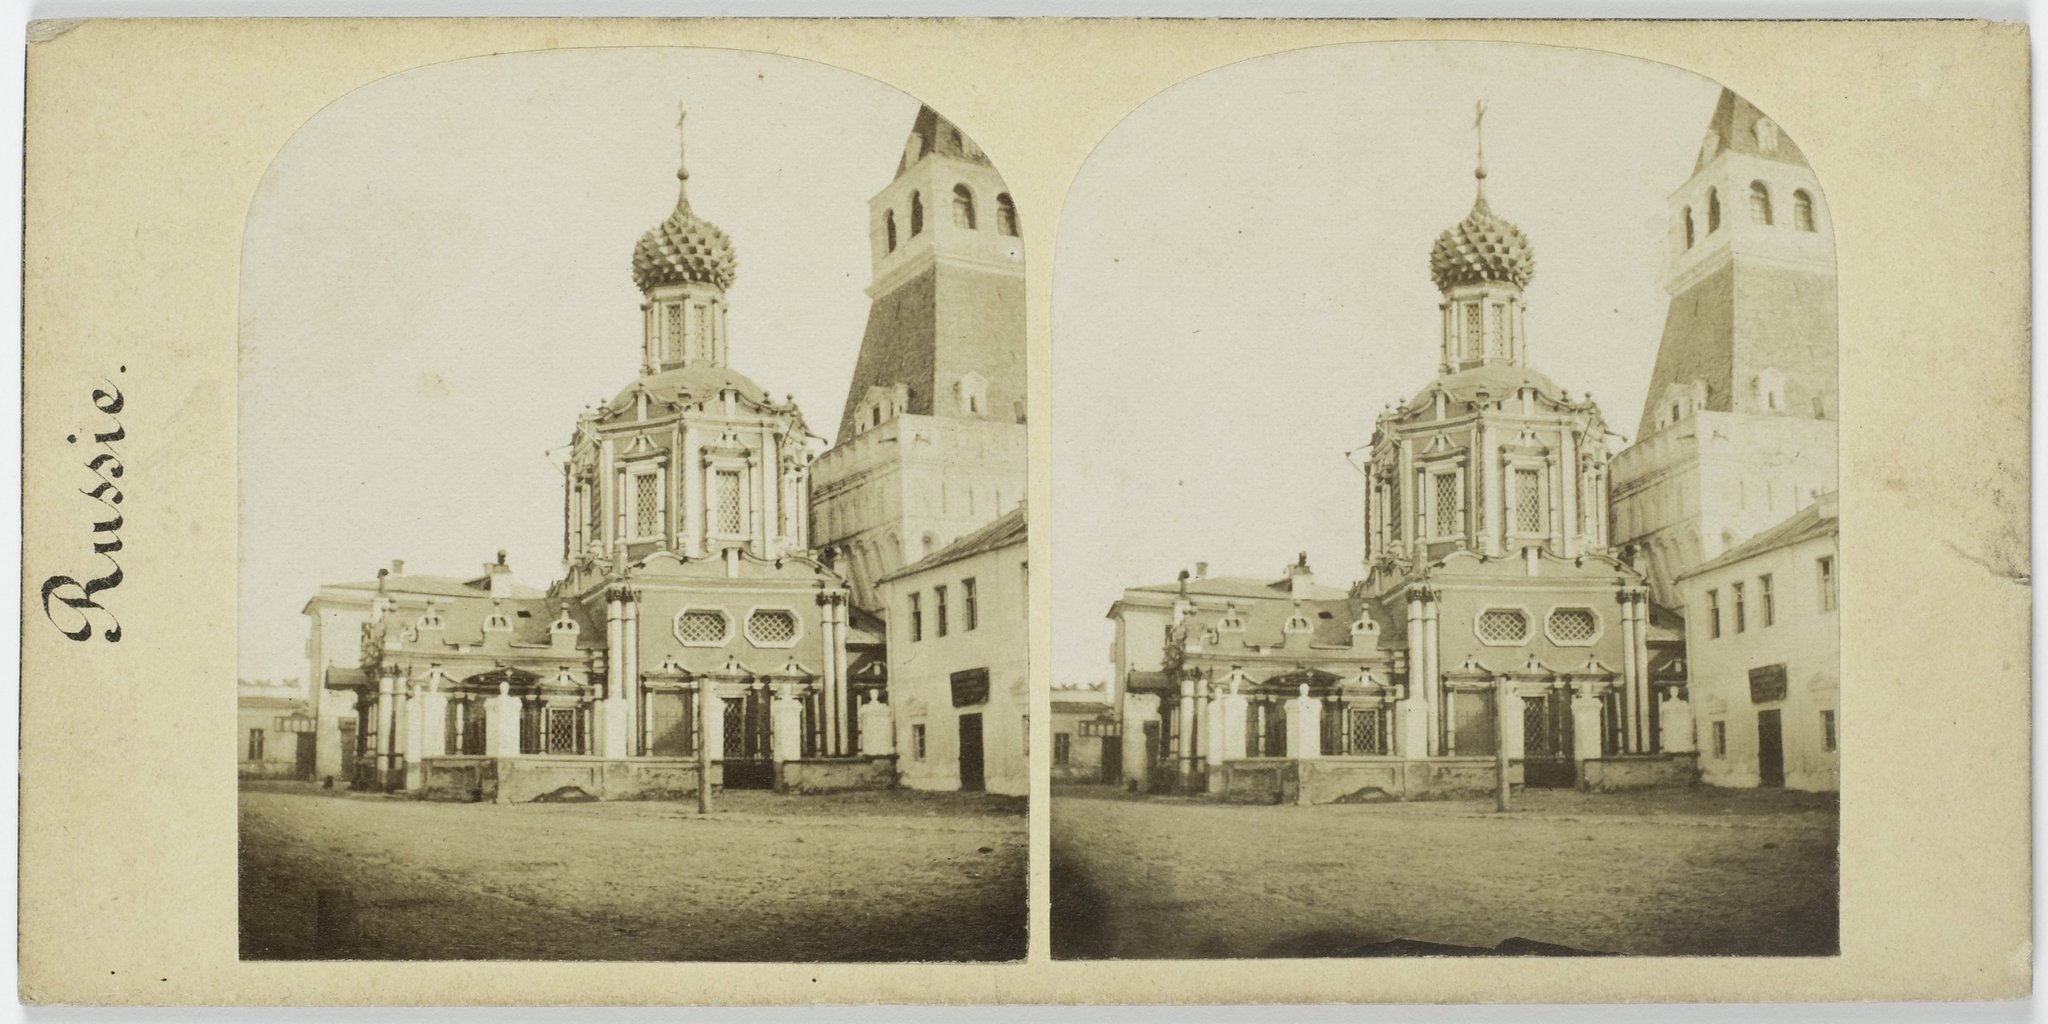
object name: stereograph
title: Exterieur van een kerk te Moskou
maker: Anonymous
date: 1850-1880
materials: cardboard, photographic support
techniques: albumen print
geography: moscow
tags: church (exterior), façade (of house or building)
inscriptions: number: ‘A28’, inscription: ‘monastère grec St. Nicolas Moscou’, inscription: ‘VOYAGE EN RUSSIE’